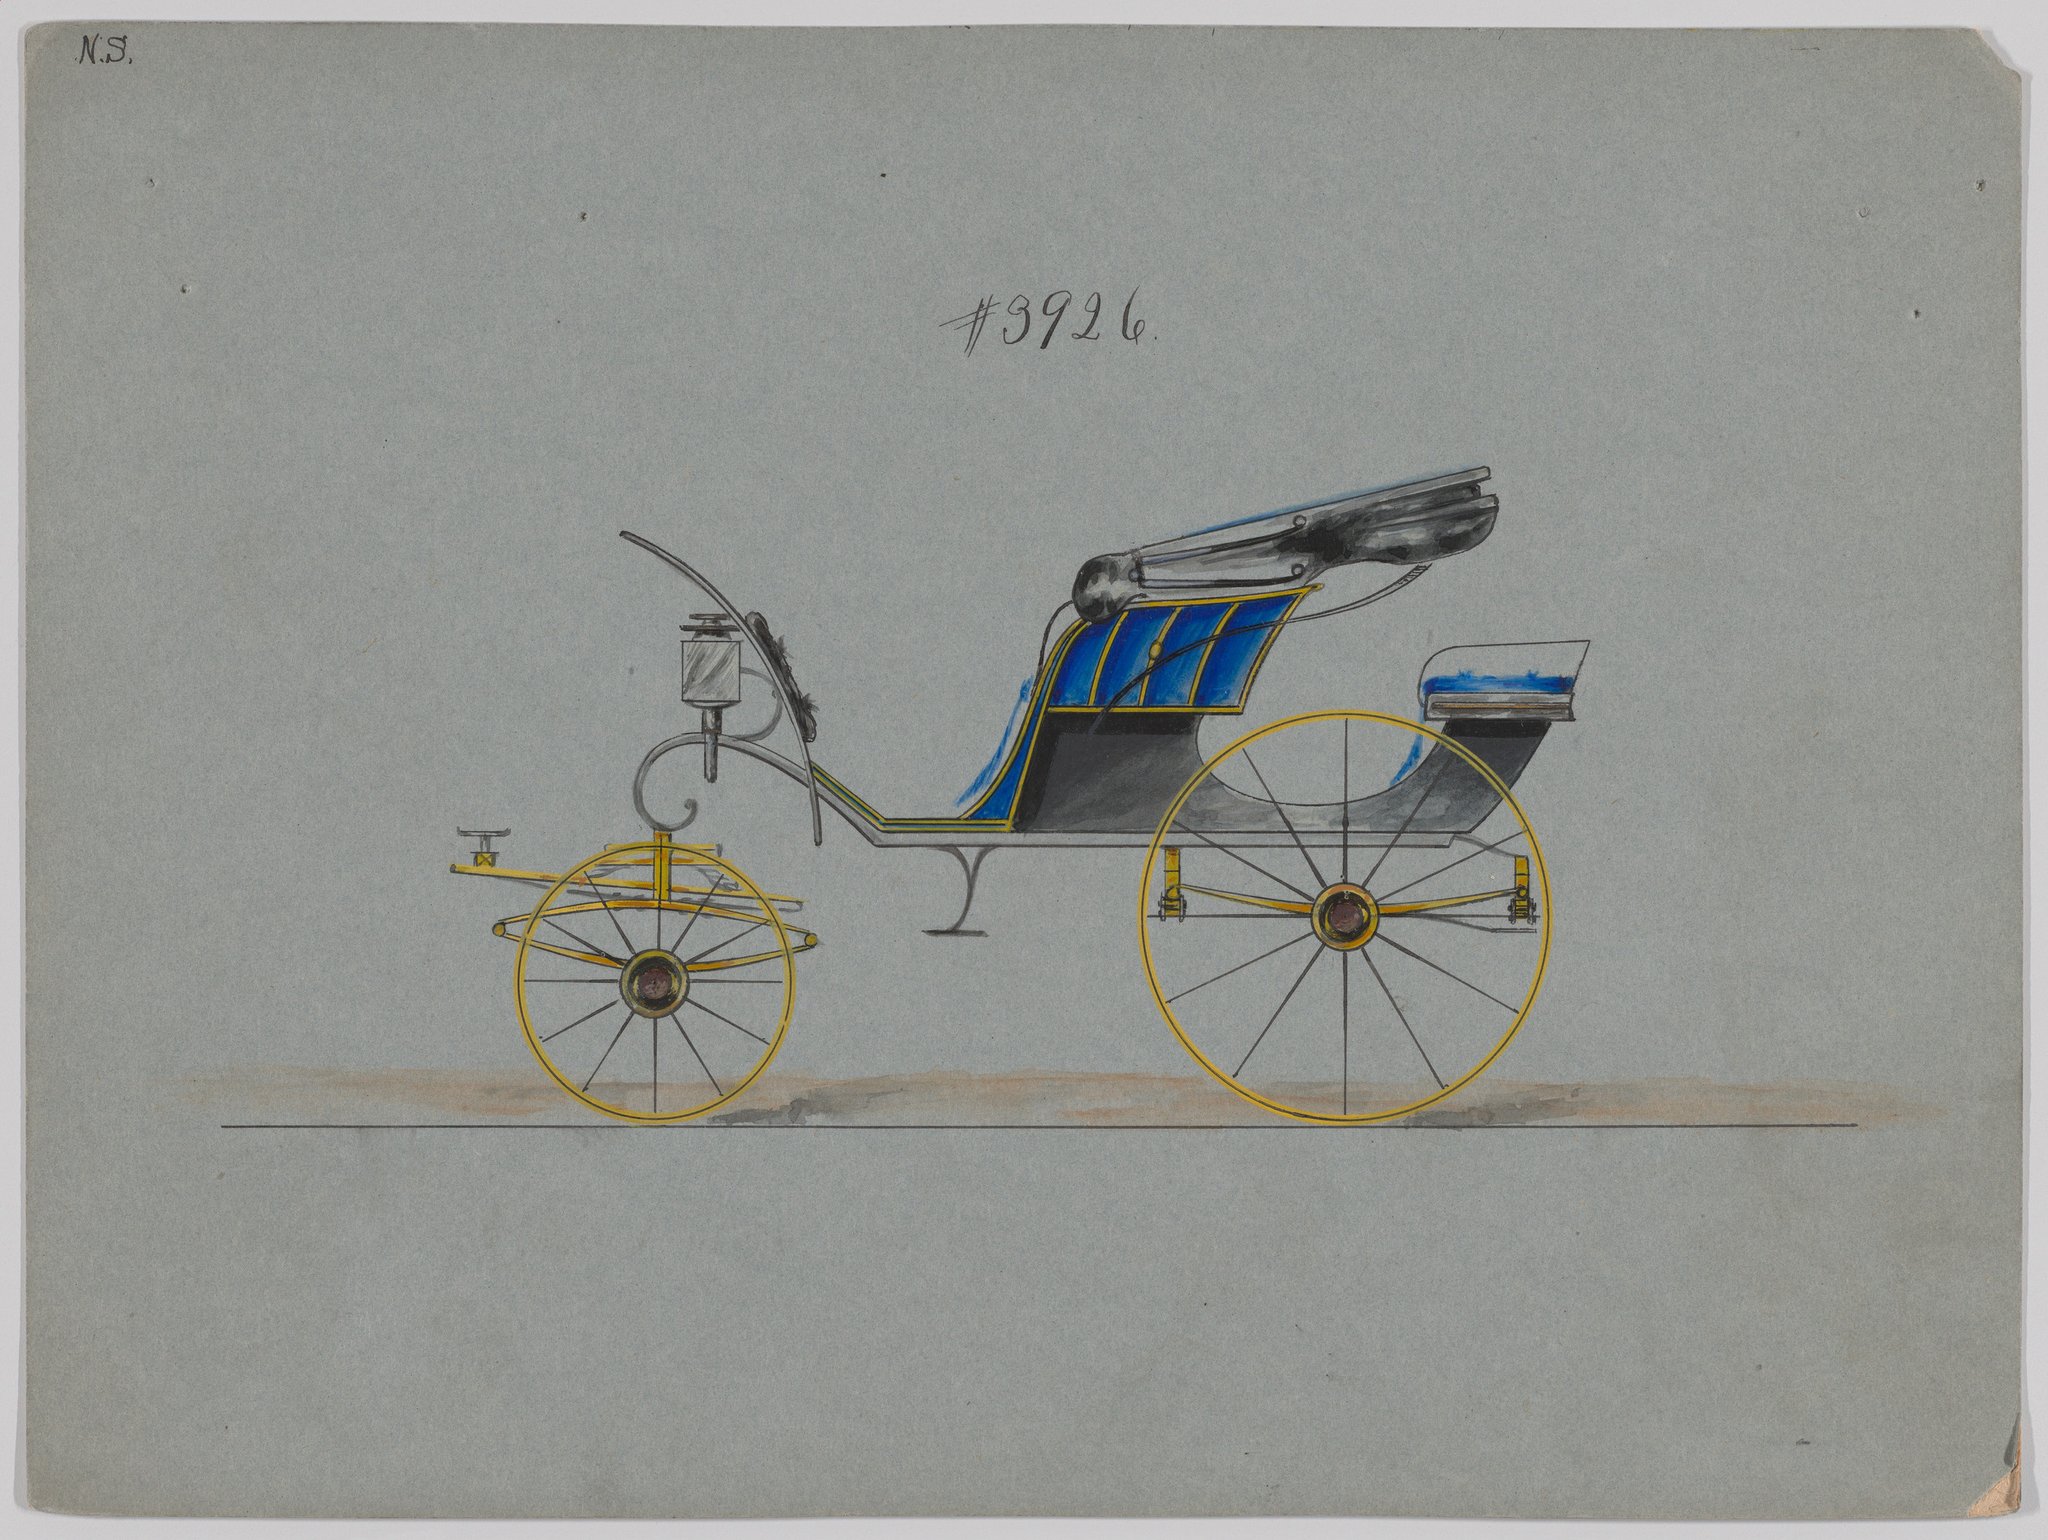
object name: drawing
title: Design for Pony Phaeton, no. 3926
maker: brewster & co.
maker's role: manufacturer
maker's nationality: american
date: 1884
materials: gouache, gum arabic, ink, watercolor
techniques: pen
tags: carriages